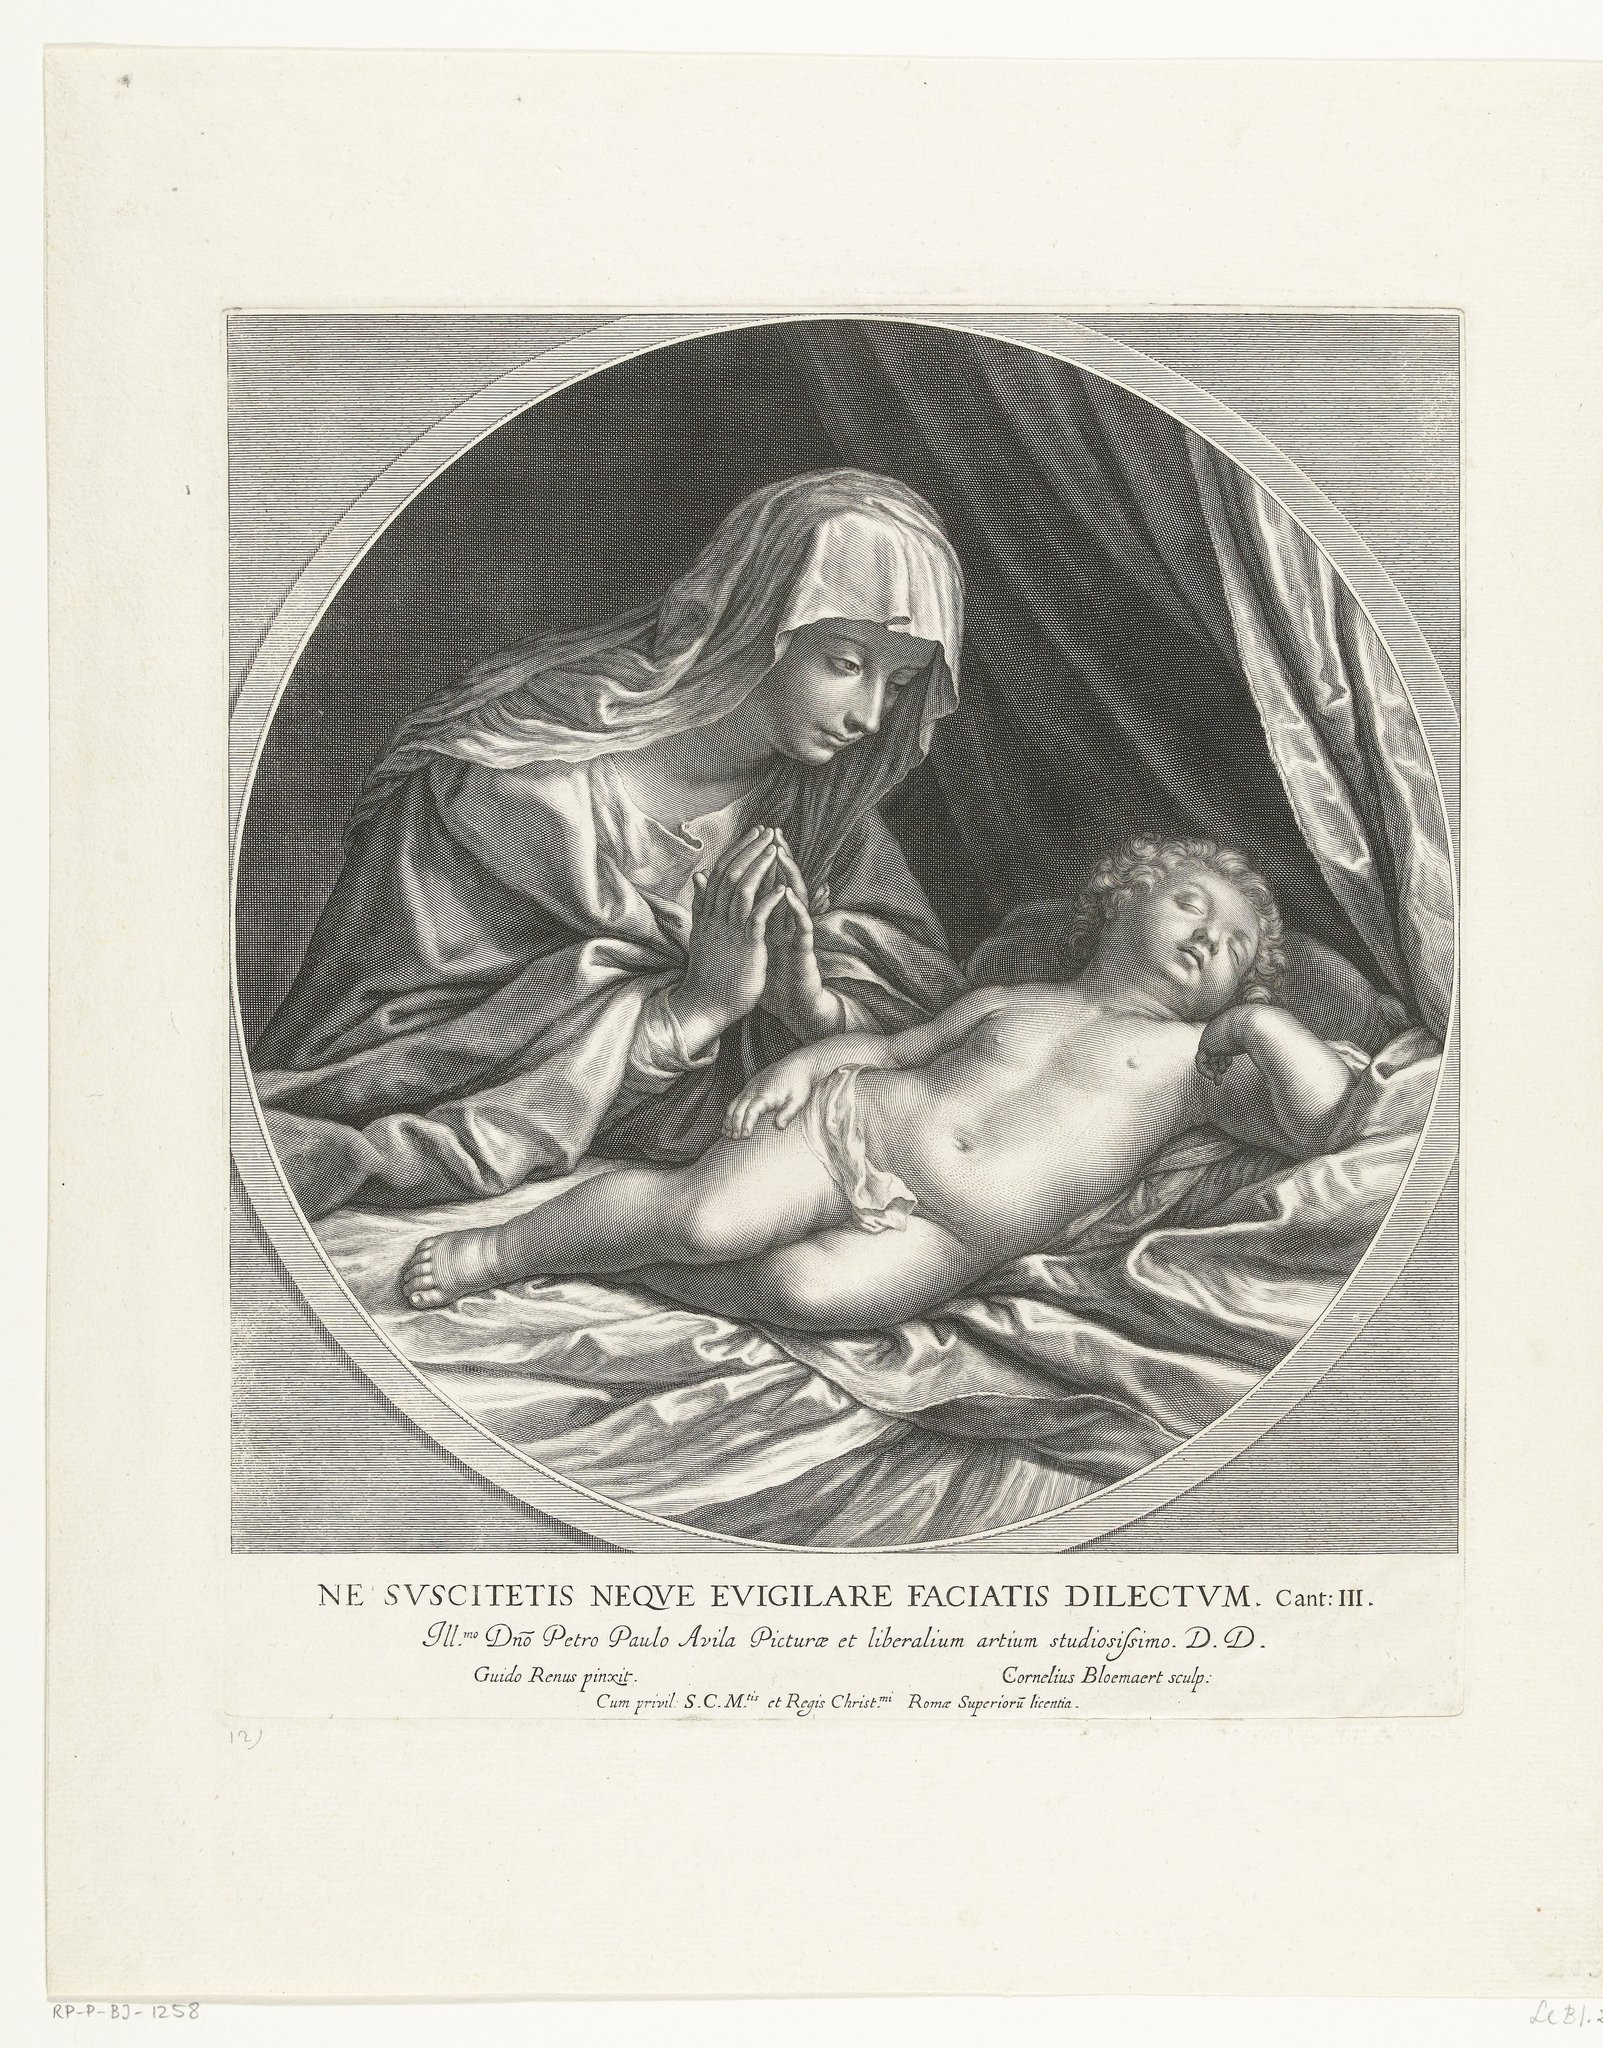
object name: print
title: Maria aanbidt het kind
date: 1633-1692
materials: paper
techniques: engraving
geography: rome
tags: mary kneeling (on the ground), the christ-child in front of her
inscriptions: collector's mark: Lugt 240, collector's mark: Lugt 2228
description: Het Christuskind ligt op een bed te slapen. Maria zit geknield aan het bed met de handen gevouwen.